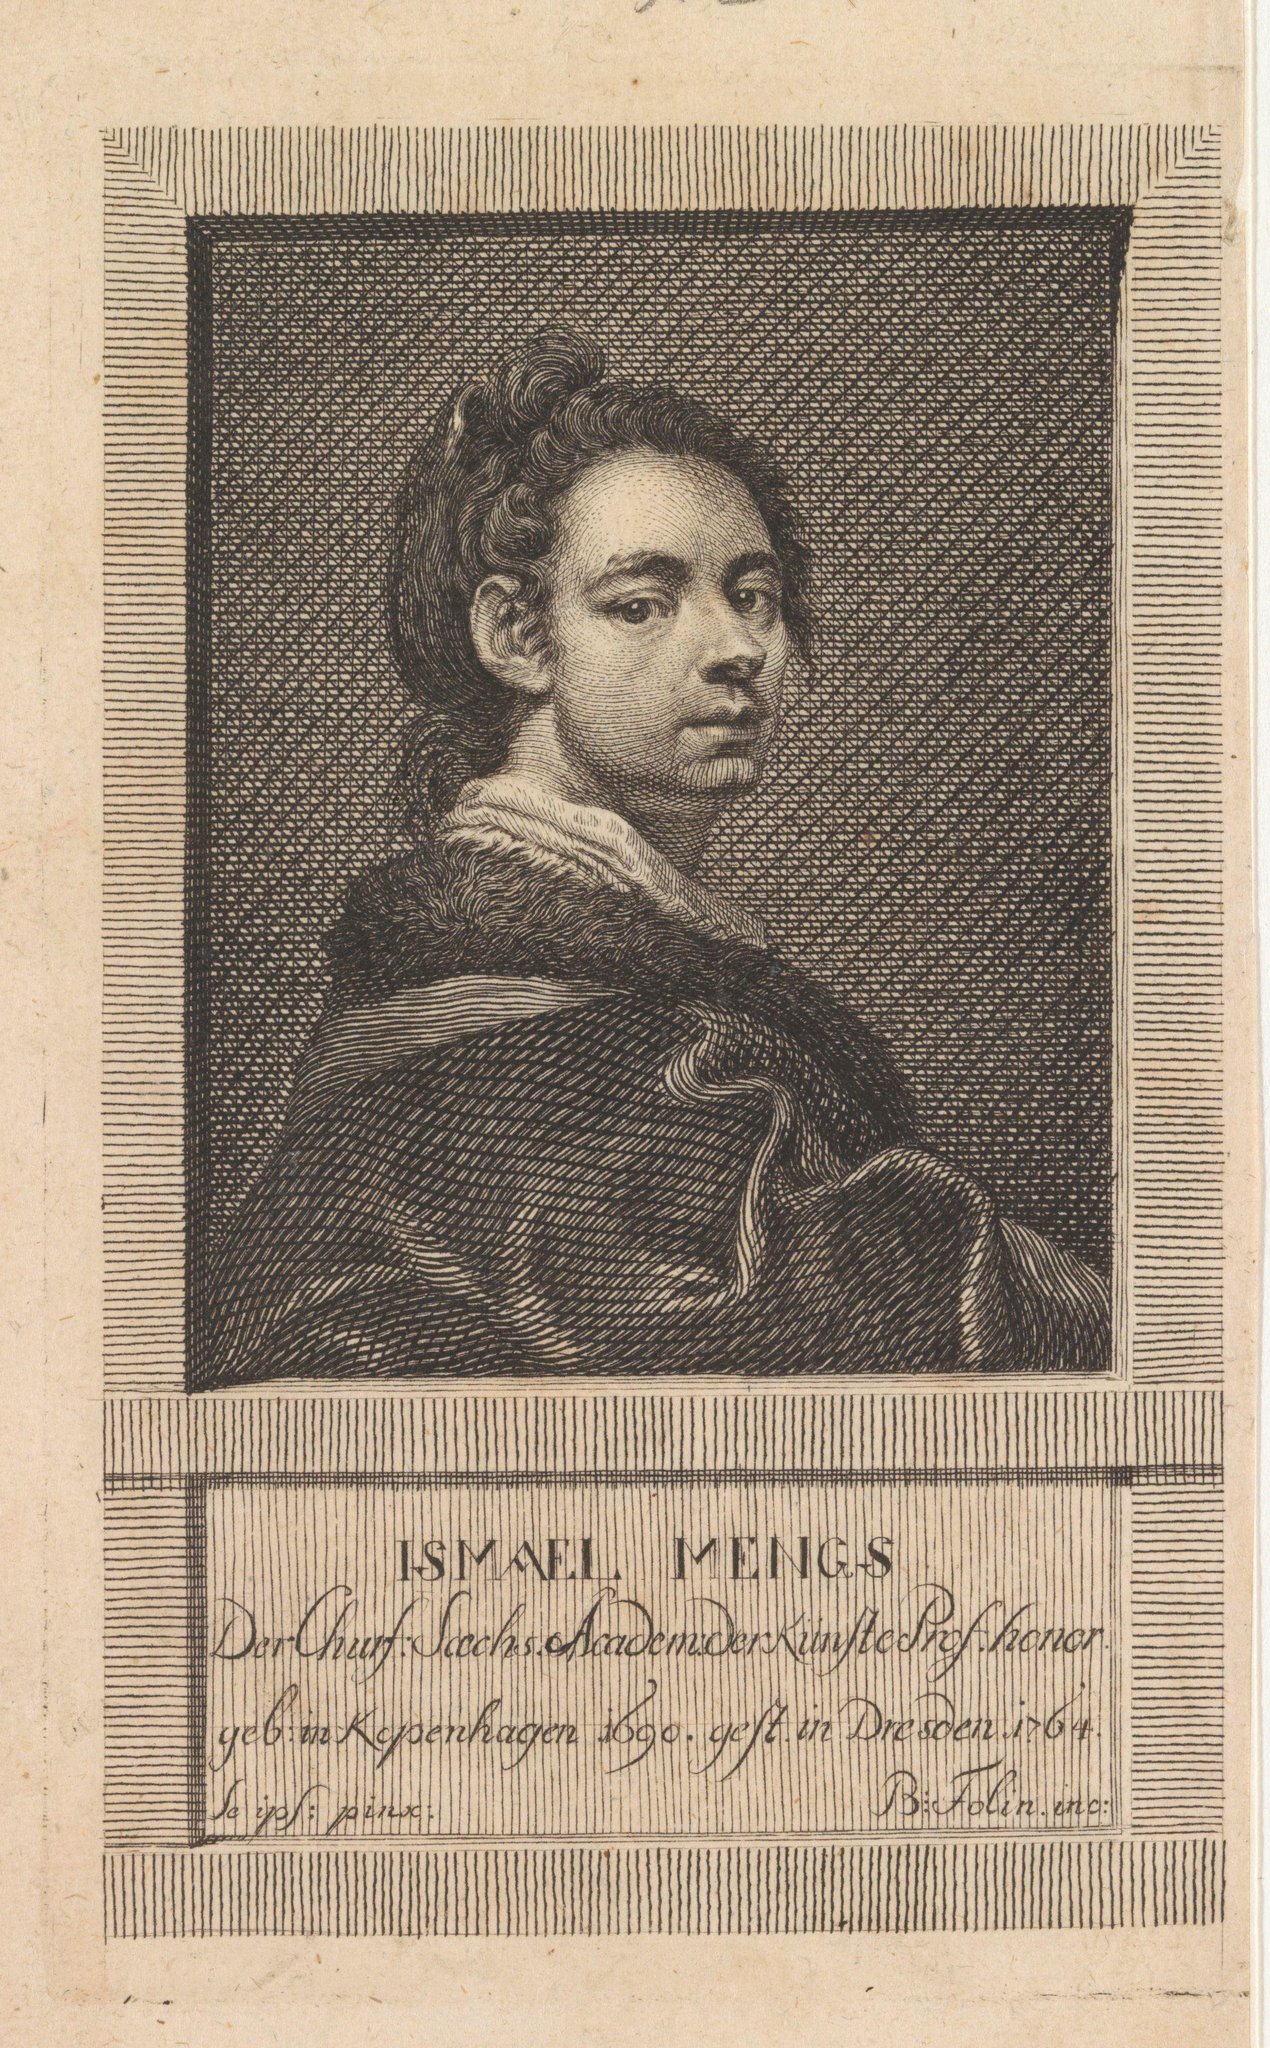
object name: print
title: Portret van schilder Ismael Mengs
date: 1740-1808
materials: paper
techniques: engraving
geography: italy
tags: copenhagen (city), painter, ismael mengs, historical persons, portrait, self-portrait of artist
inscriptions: collector's mark: Lugt 2228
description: Naar een geschilderd zelfportret door Mengs.